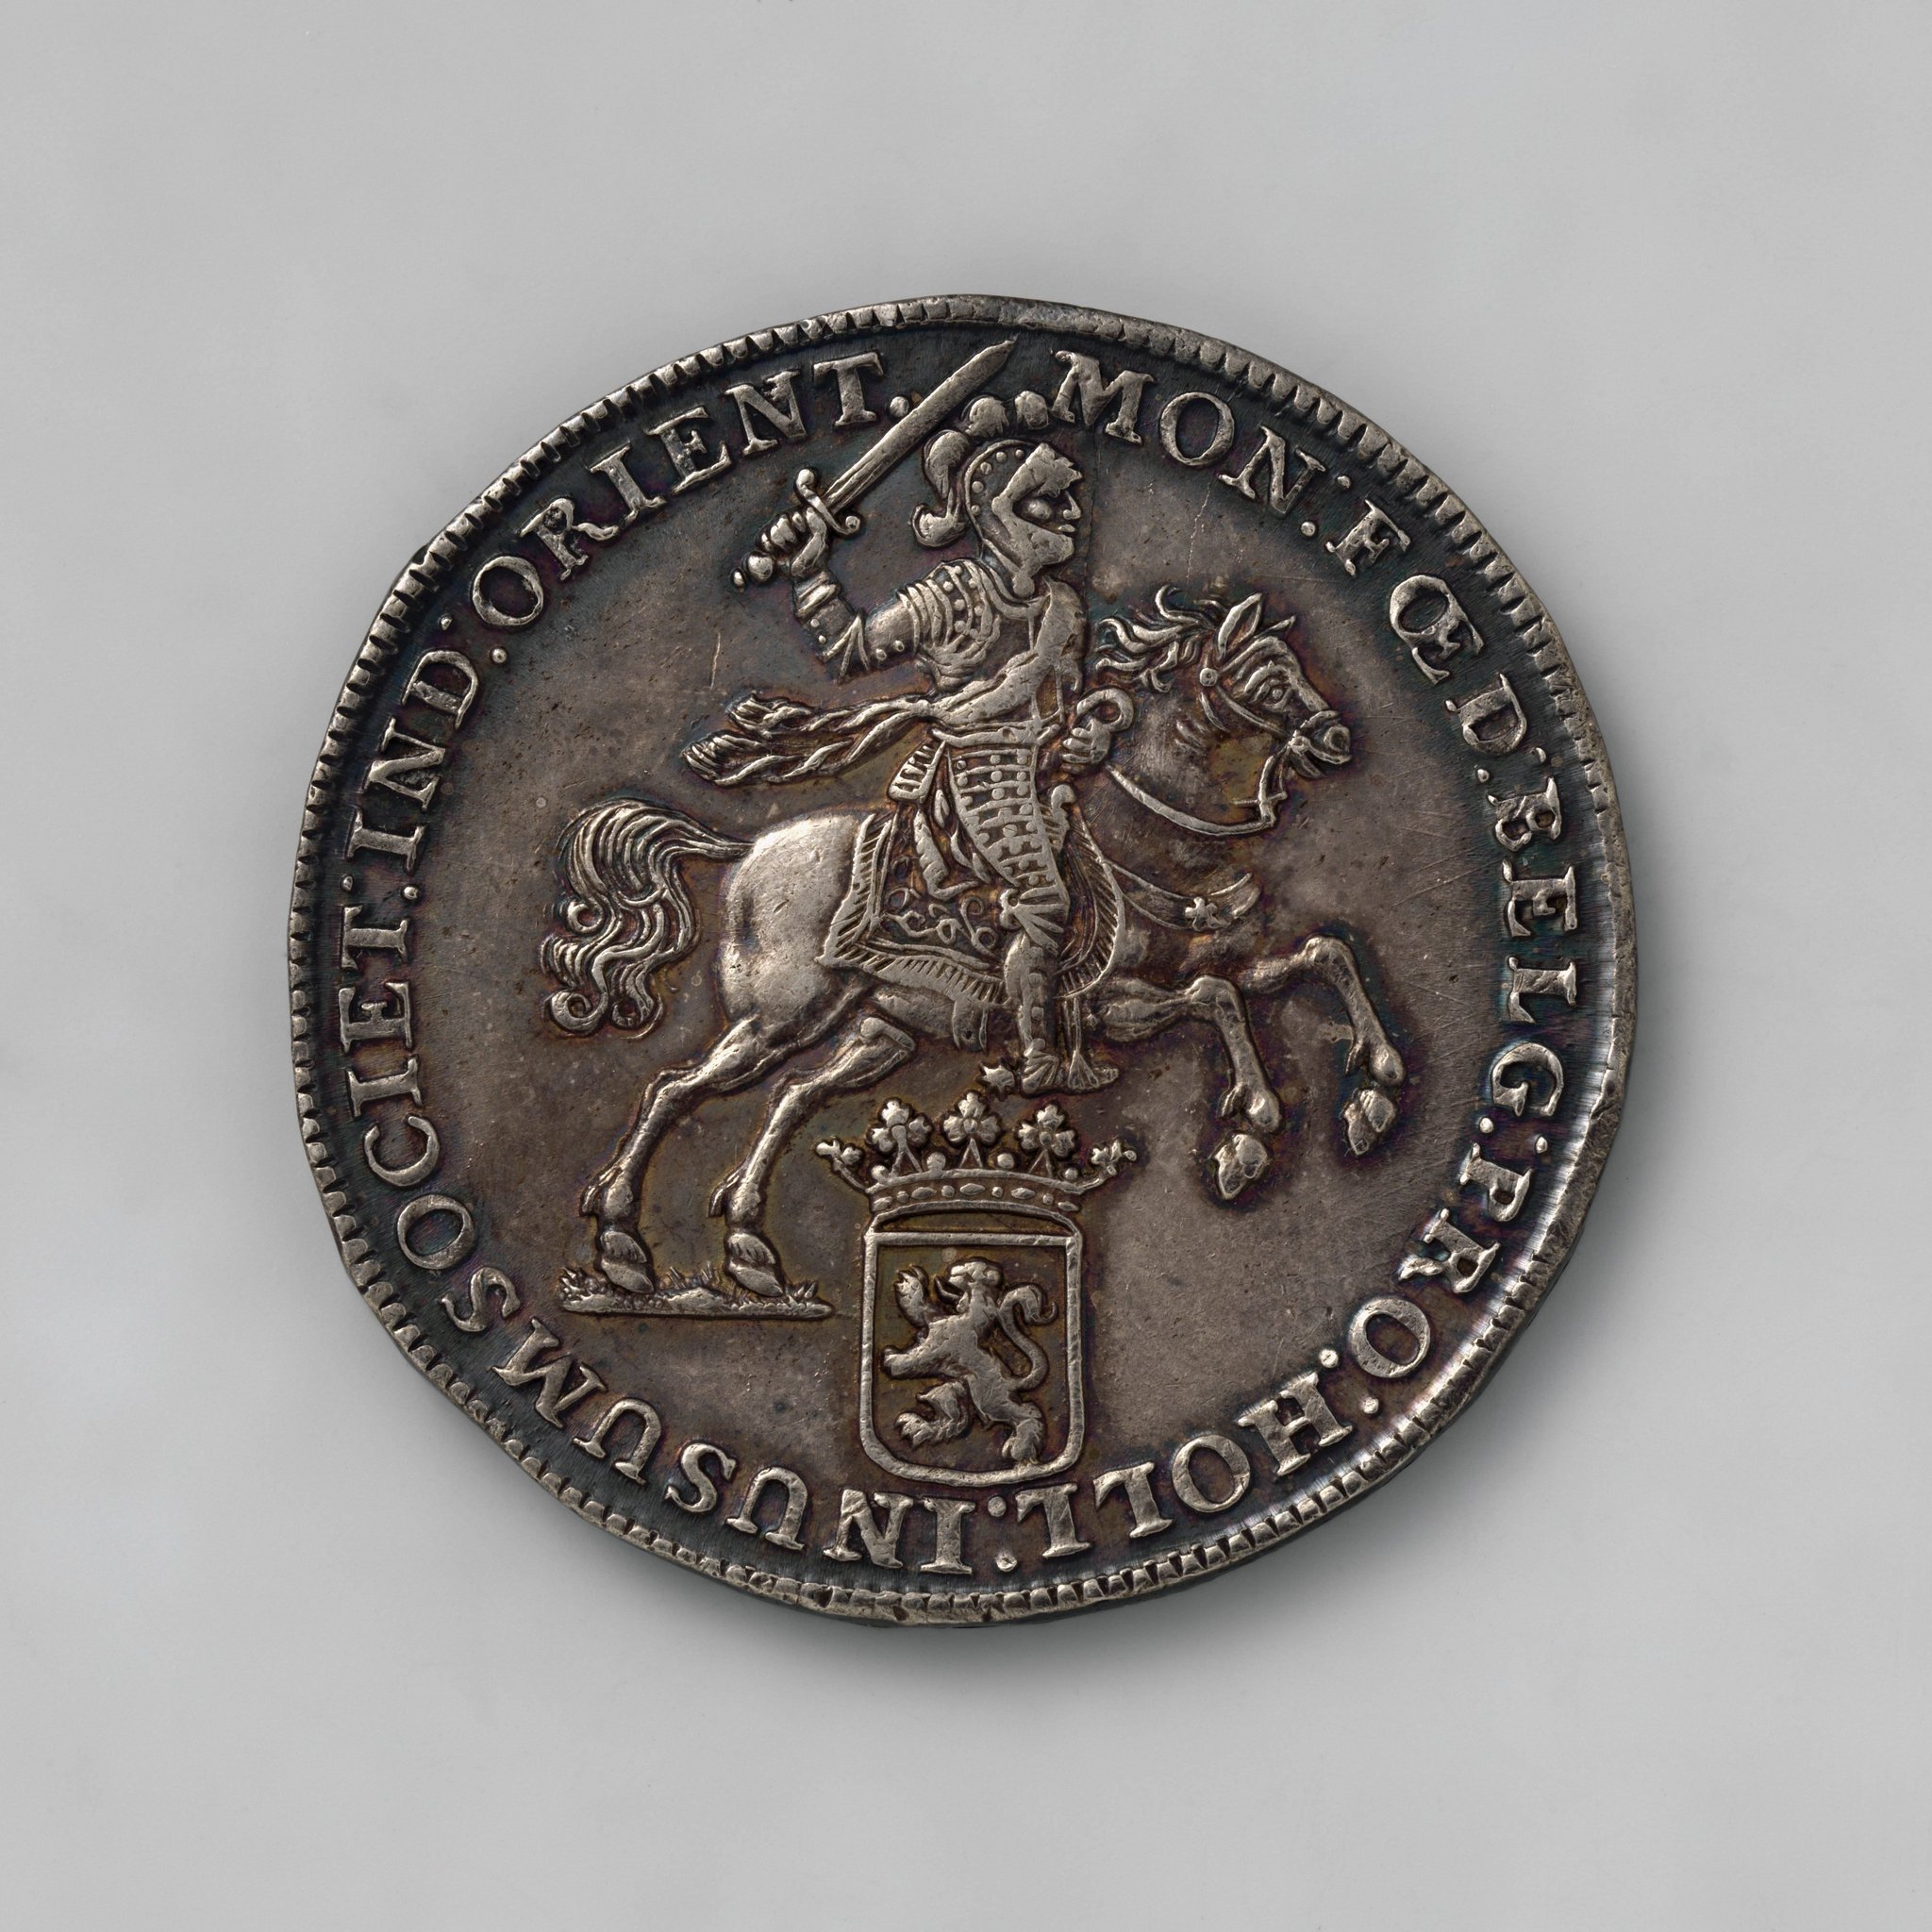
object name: silver rider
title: Zilveren rijder van de VOC uit Holland, 1739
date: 1739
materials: silver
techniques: striking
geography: dordrecht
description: Zilveren munt. Voorzijde: geharnaste ridder met zwaard te paard naar rechts, waaronder gekroond wapenschild van Holland. Keerzijde: gekroond generaliteitswapenschild, waaronder cartouche, waarin monogram van de VOC. Jaartal in omschrift, boven kroon. Gladde rand.